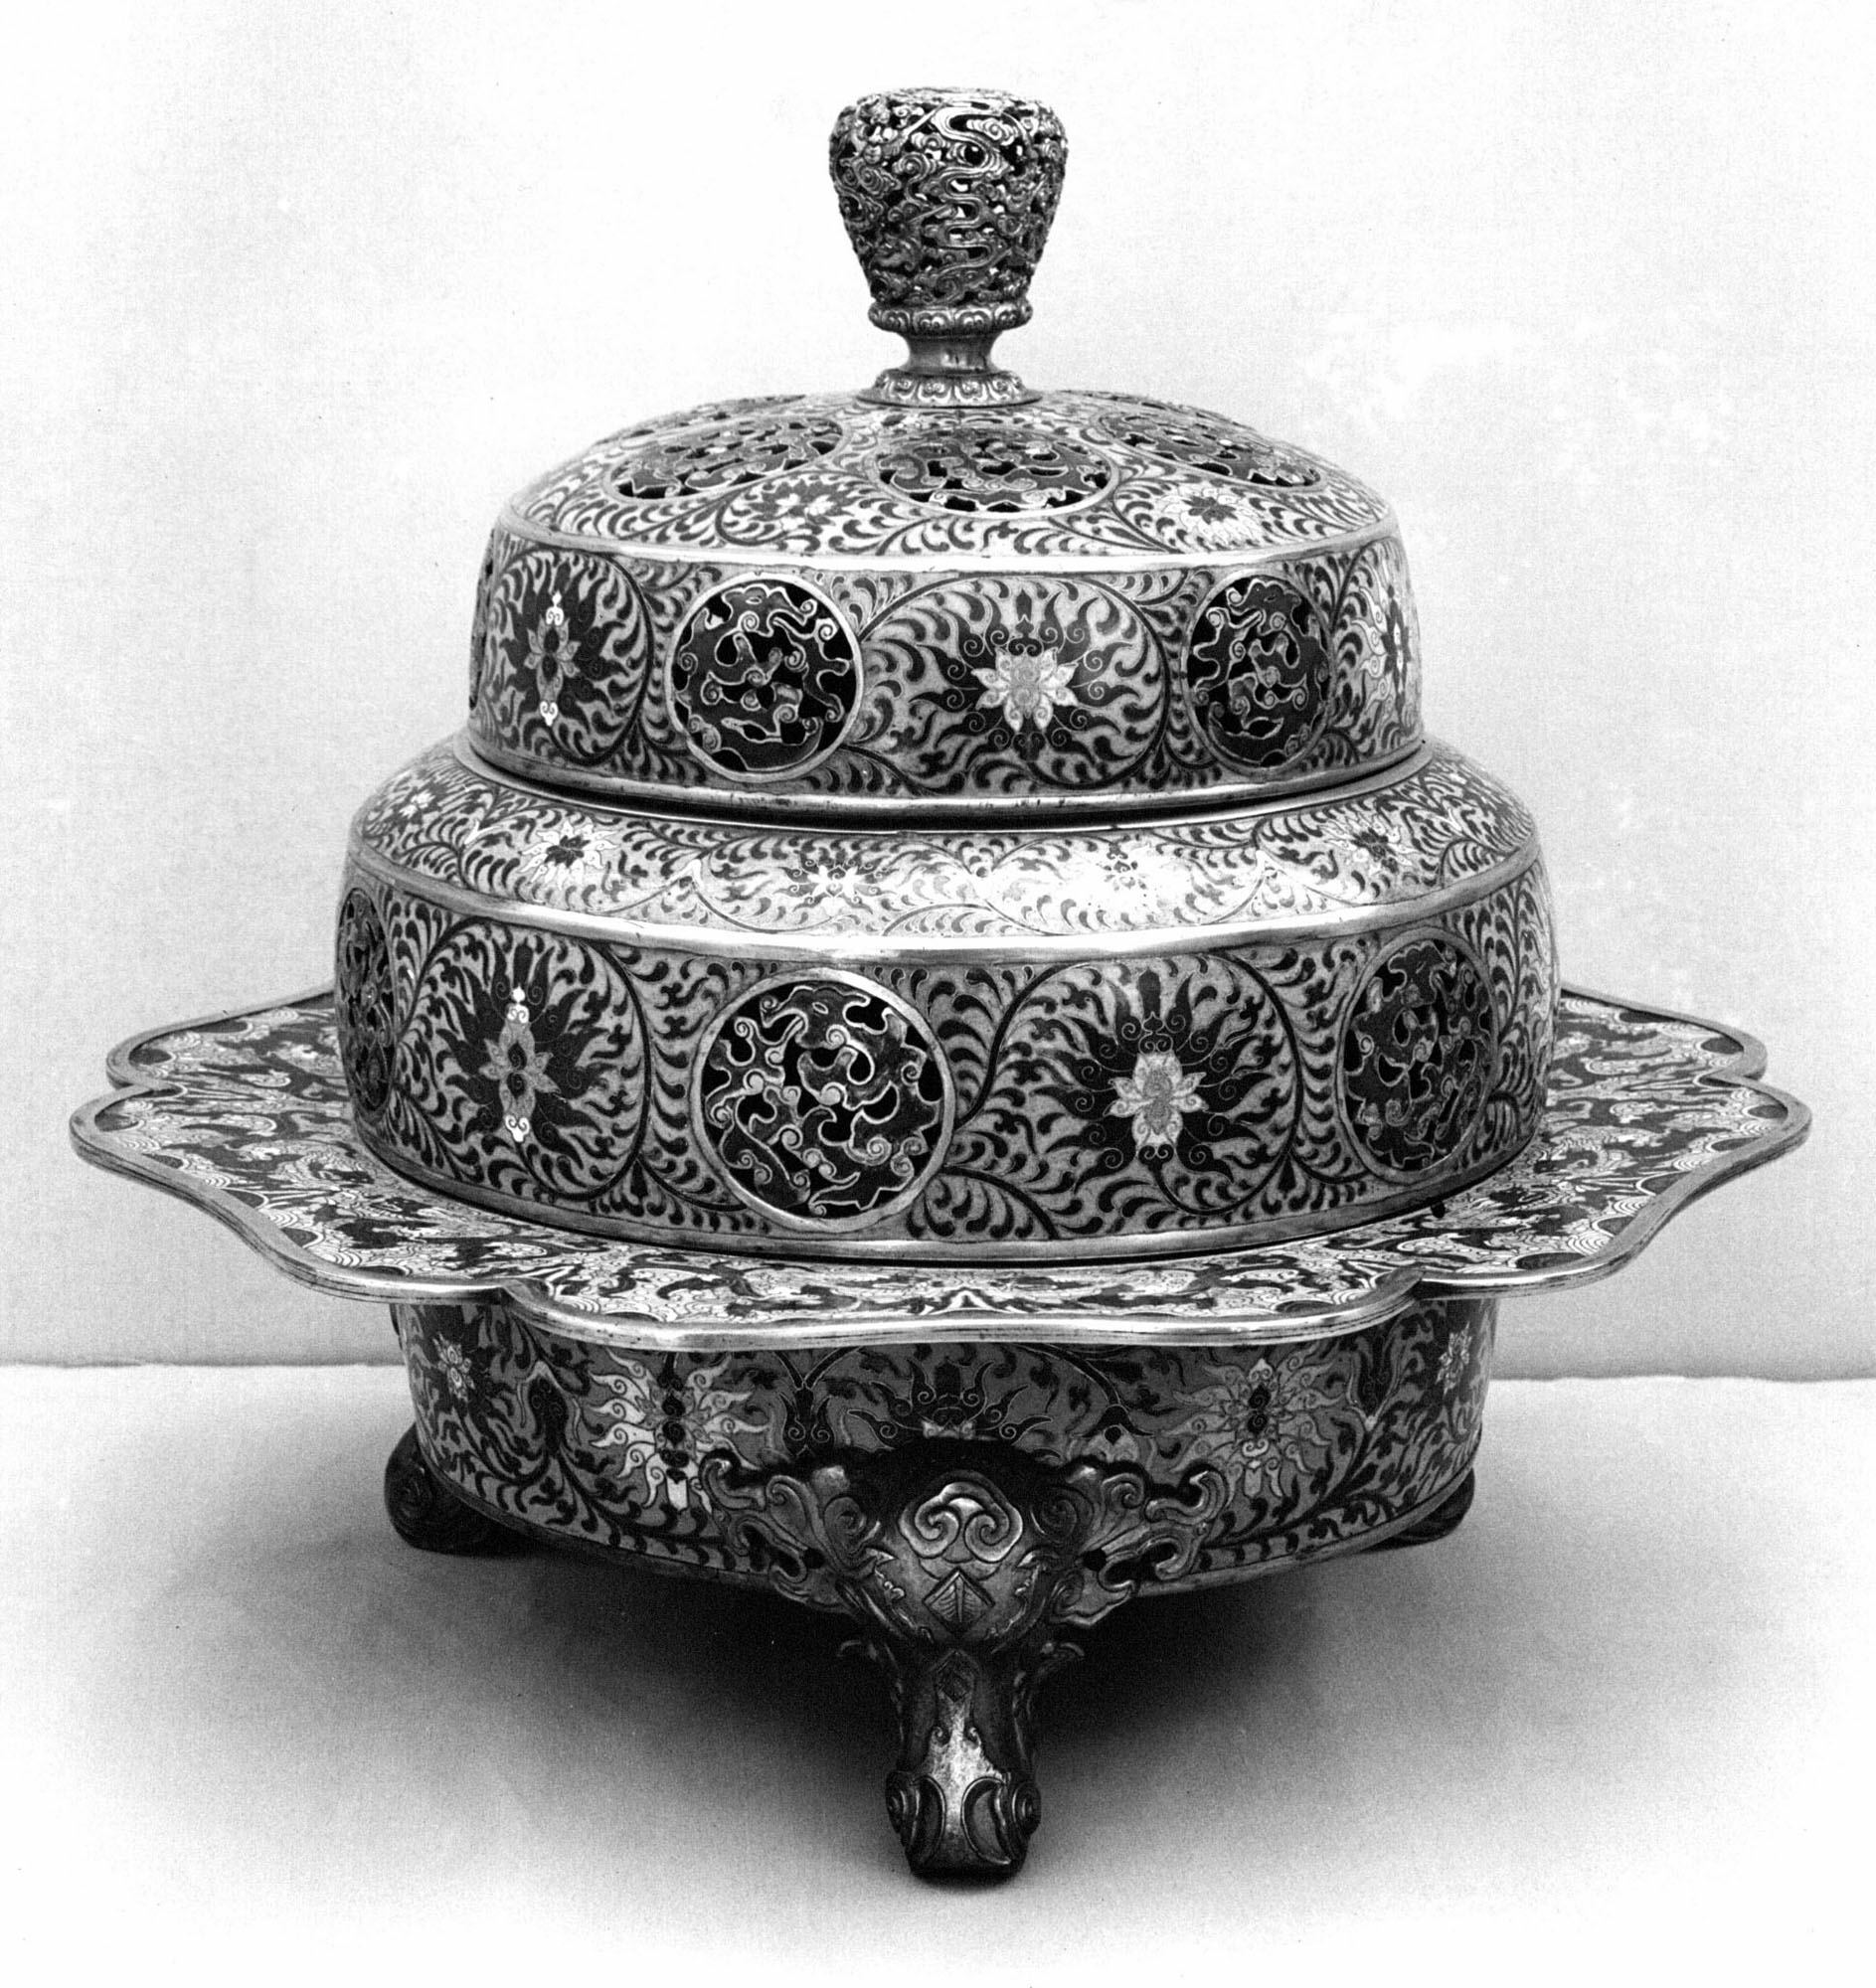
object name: incense burner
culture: chinese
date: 1801-1900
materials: copper, enamel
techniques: enamel